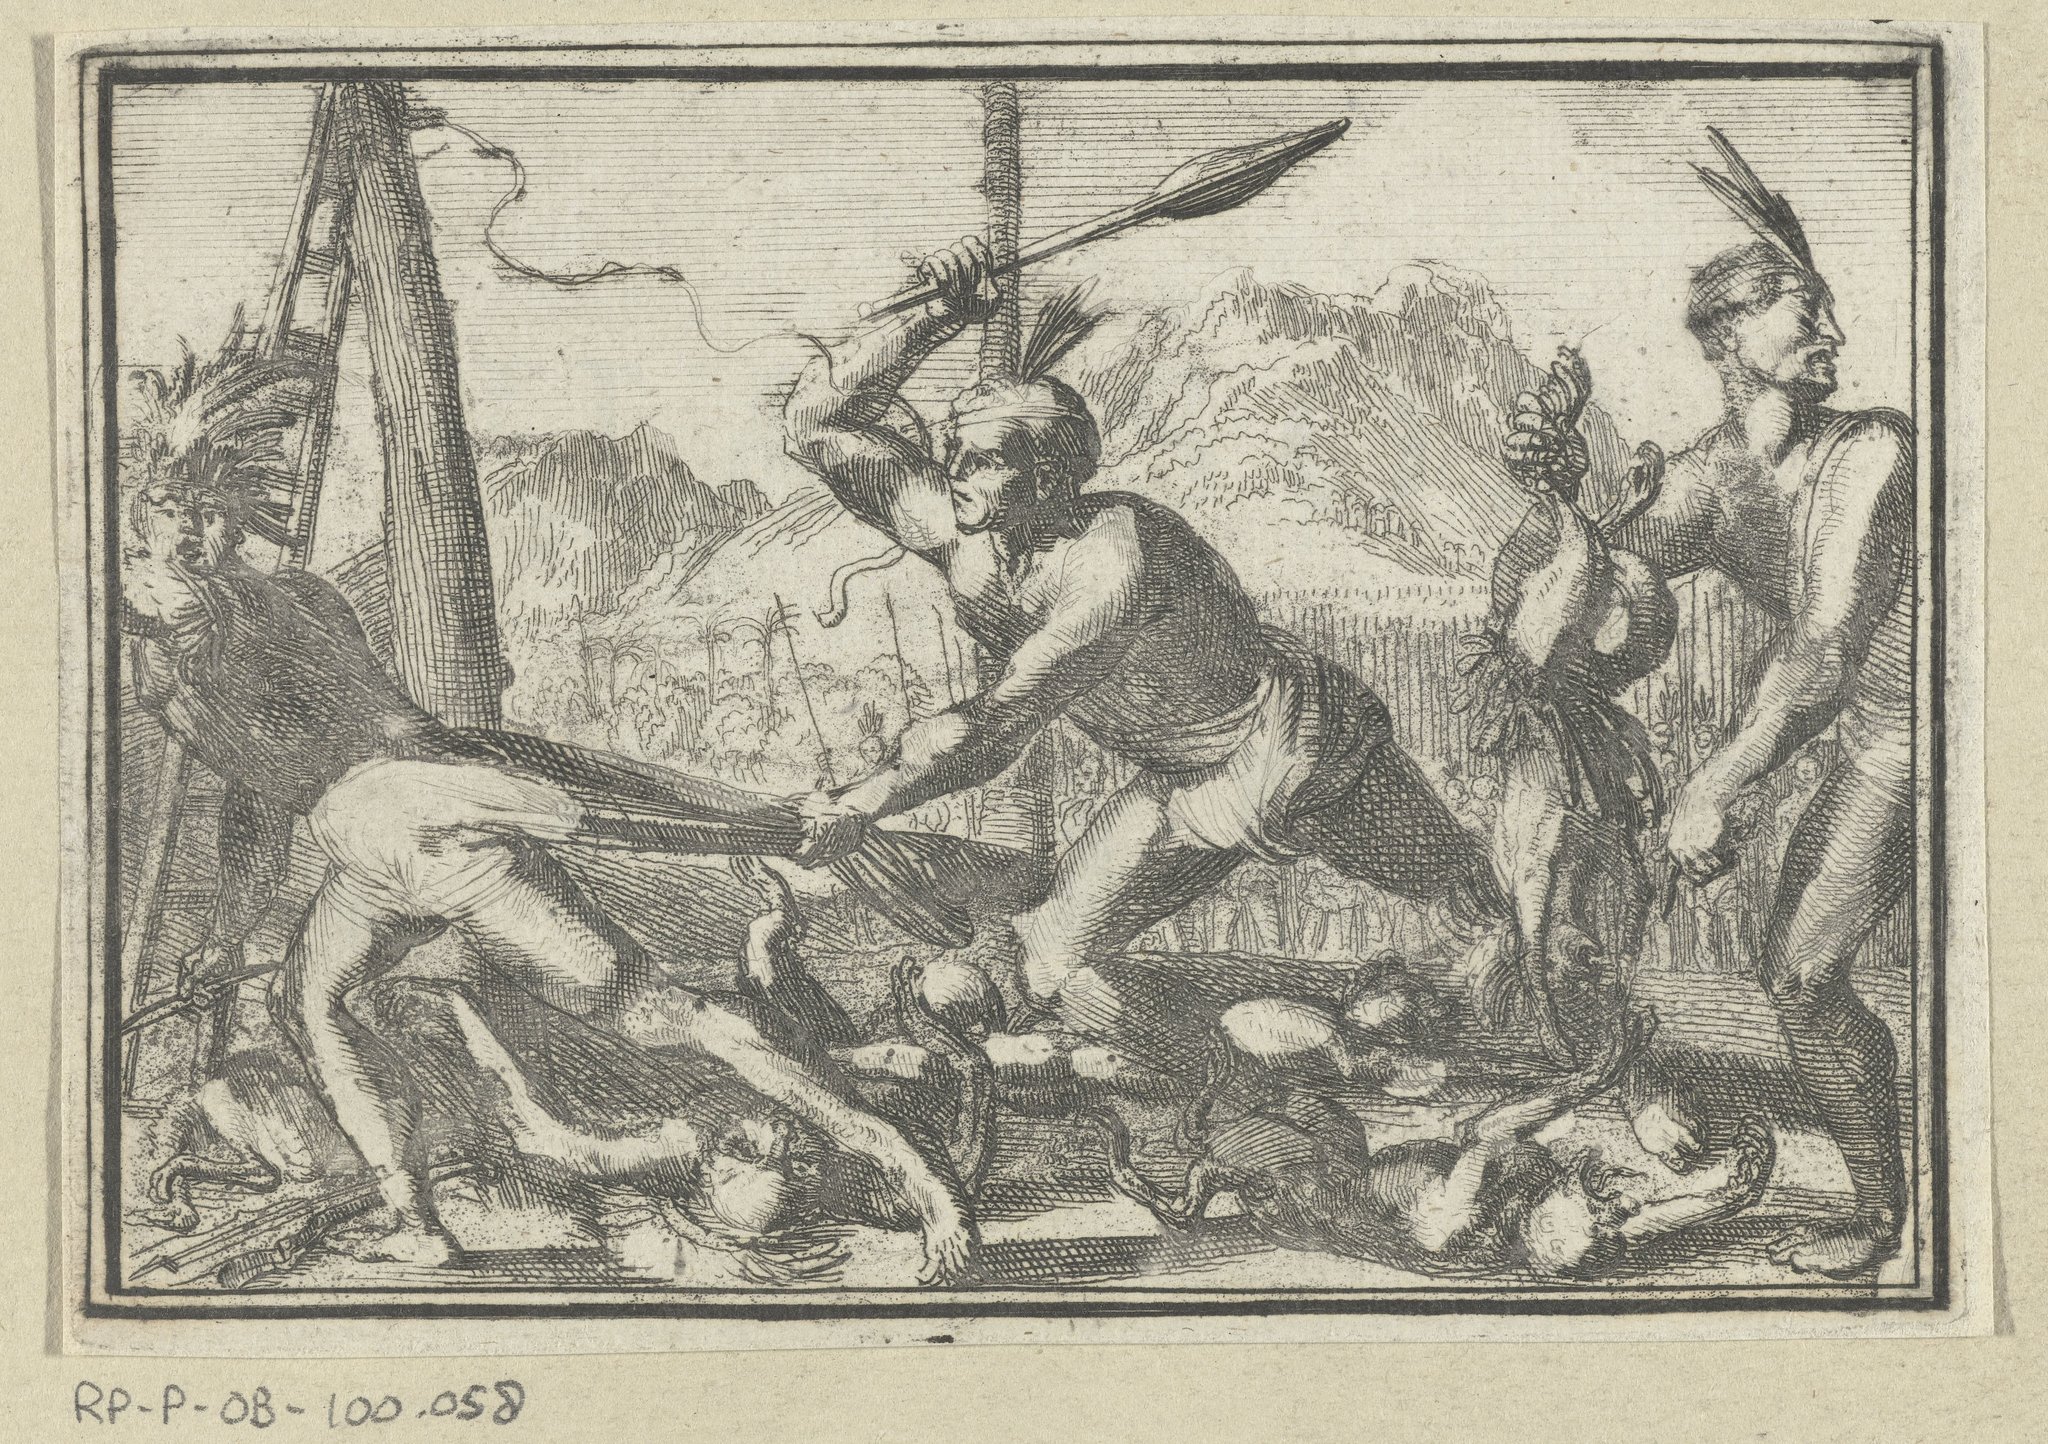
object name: titelblad, titelpagina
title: Hansop op de Koord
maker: romeyn de hooghe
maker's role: draughtsman, goldsmith, painter, print maker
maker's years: 1645-1708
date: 1701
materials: paper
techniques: etching, letterpress printing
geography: netherlands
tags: lodewijk xiv (koning van frankrijk), monkeys, apes, native peoples of the americas (+ caricatured), fowl (cock, hen, chicken, etc.), tight-ropewalker, native peoples of the americas, political caricatures and satires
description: Een gebroken koord tussen twee palen, op de grond liggen kermende apen. In het midden een man die de vluchtende koning van Frankrijk (met veren hoofdtooi afgebeeld als oorspronkelijke bewoner van Amerika) probeert te slaan, rechts een man met een geplukte kip (Frankrijk).